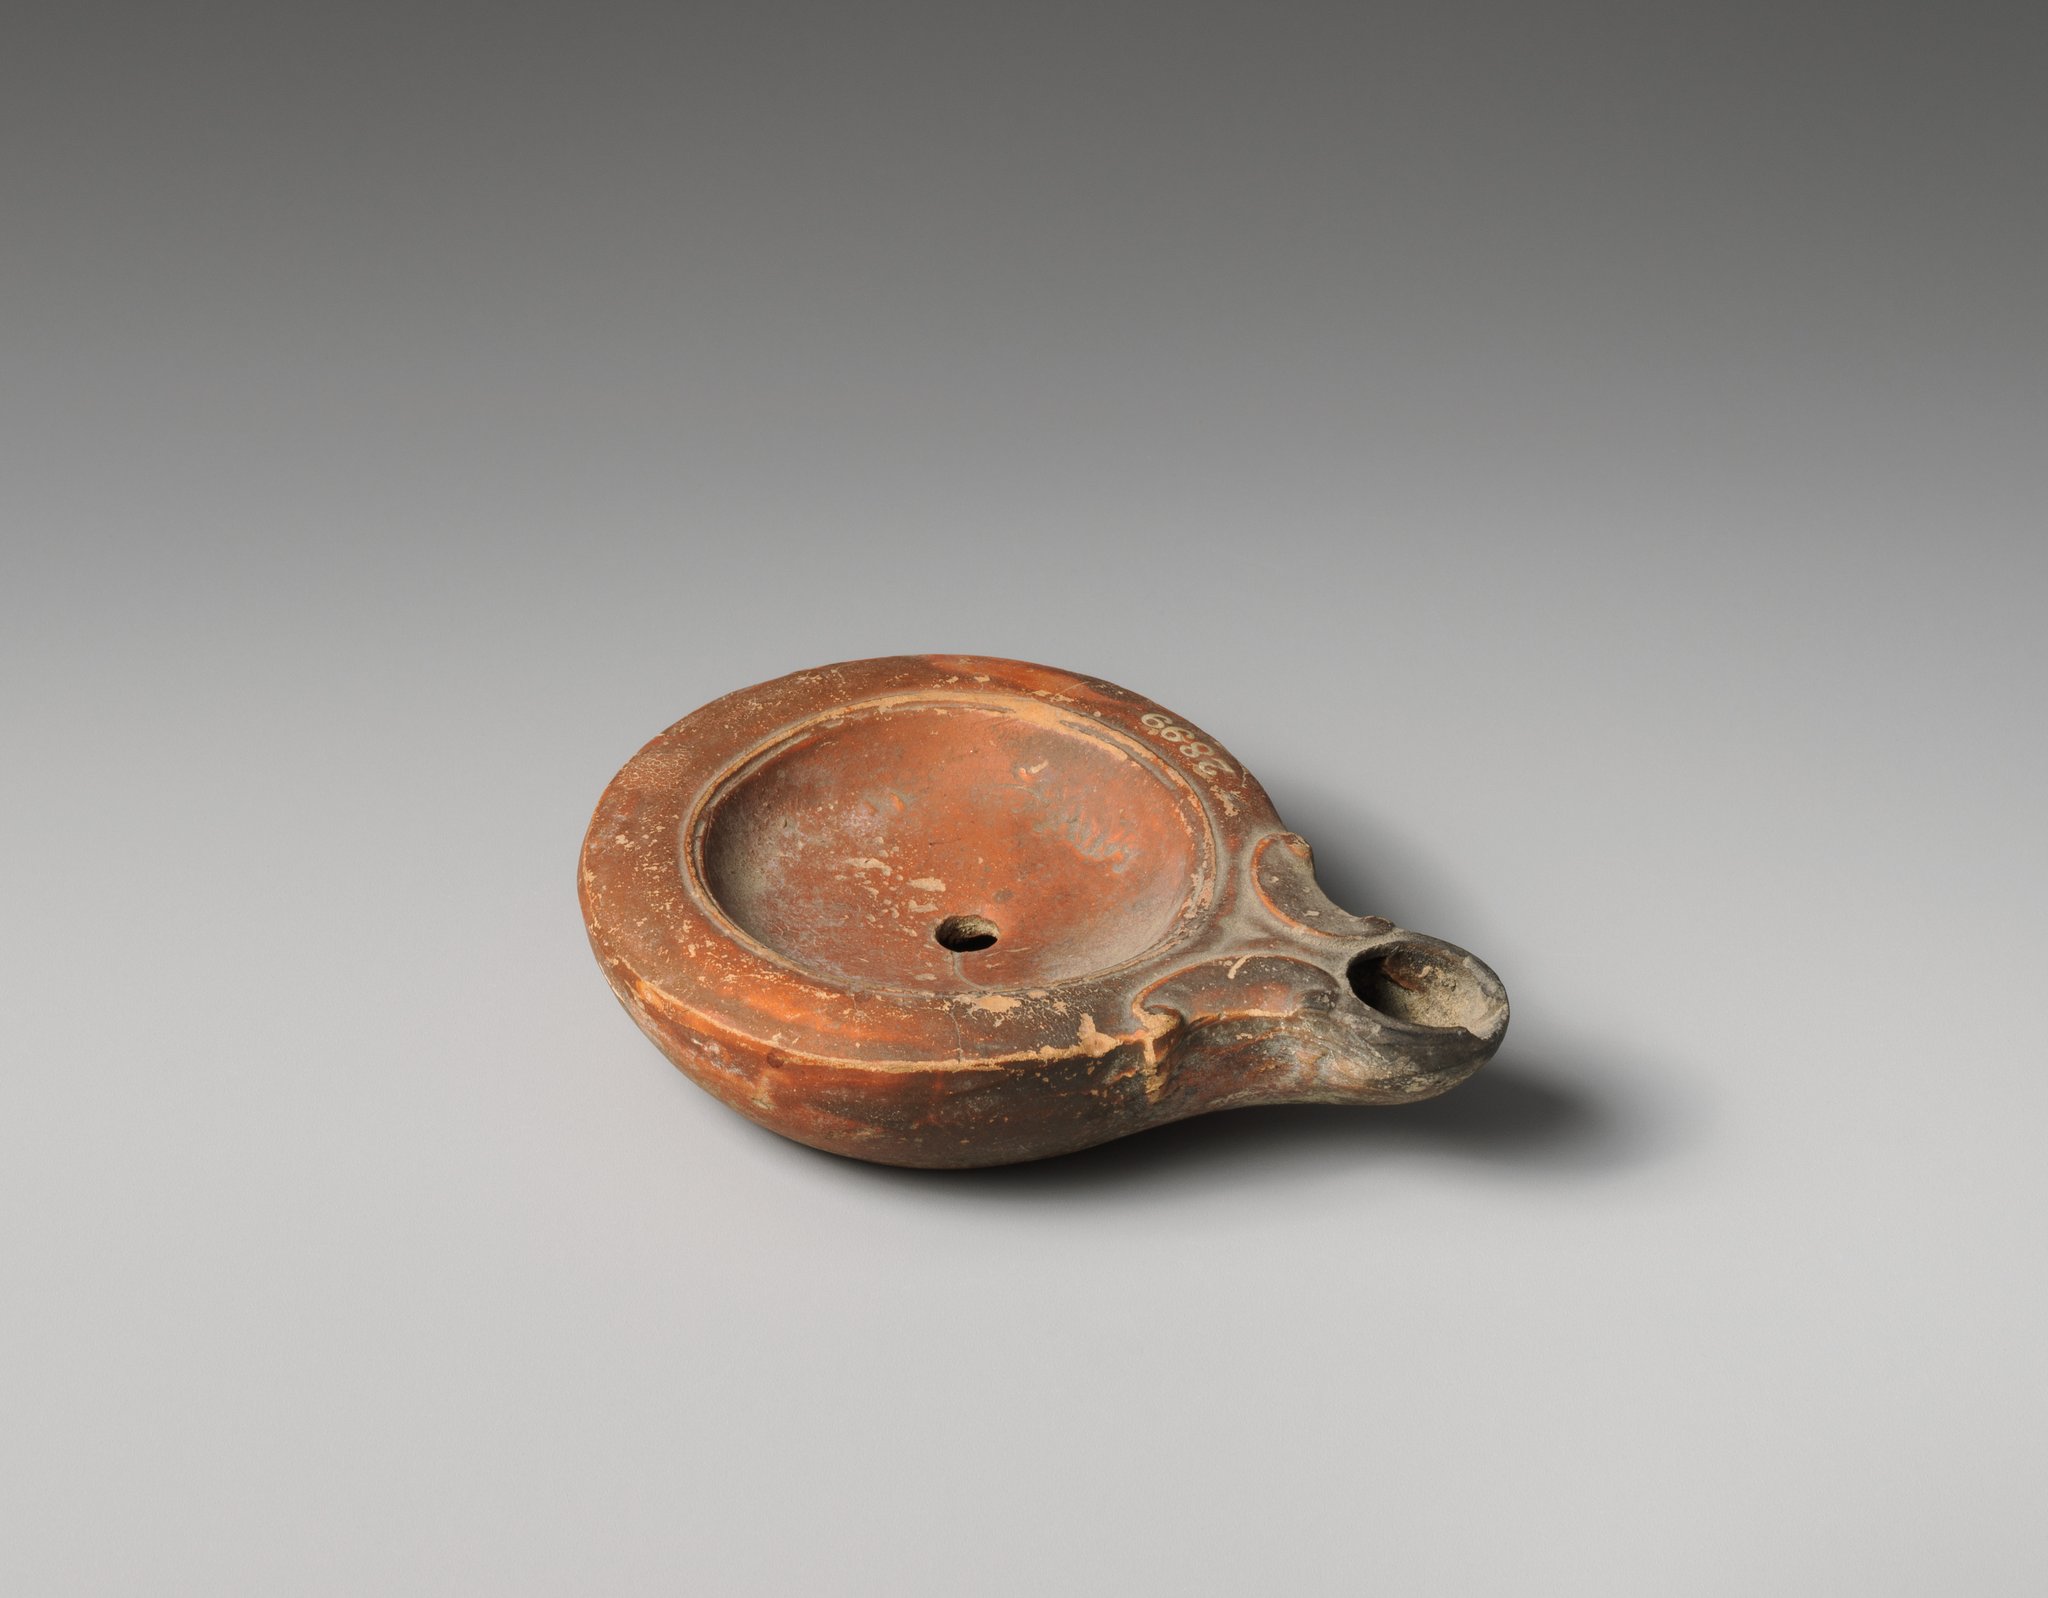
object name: lamp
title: Terracotta oil lamp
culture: roman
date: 40-100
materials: terracotta